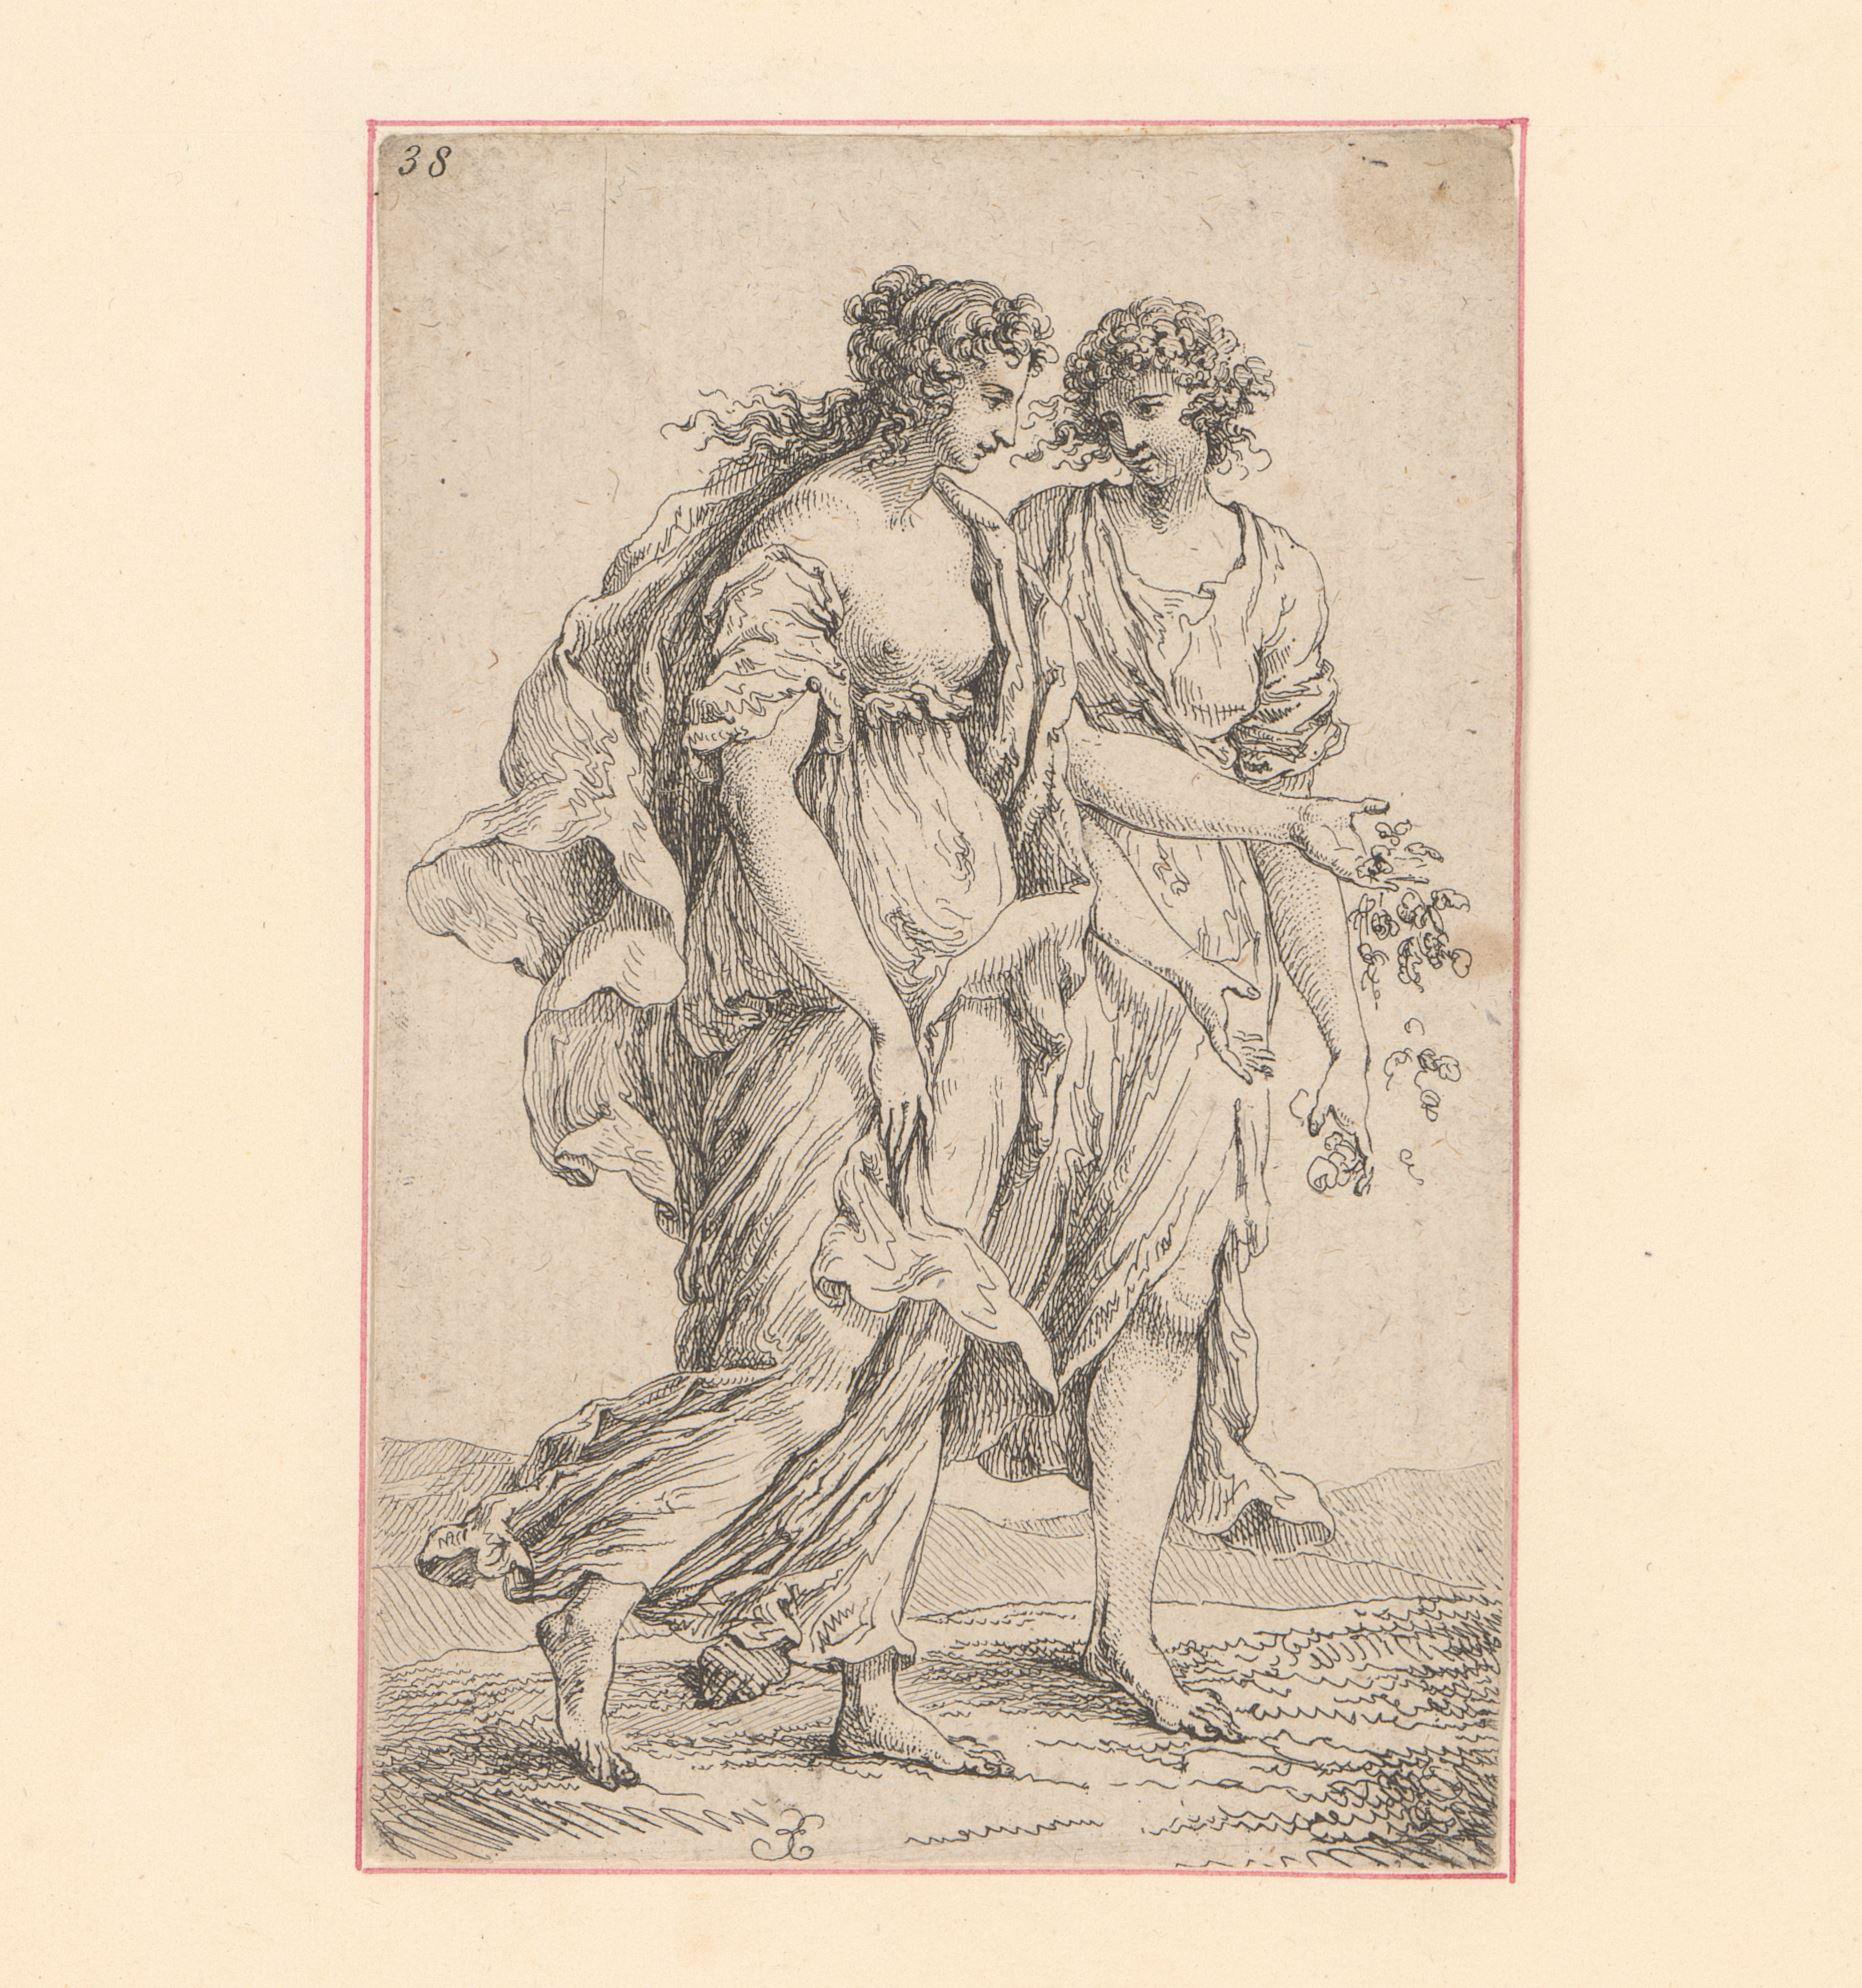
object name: album leaf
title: Etchings by E. Edwards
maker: edward edwards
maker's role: painter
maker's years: 1738-1806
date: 1748-1806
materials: paper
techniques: etching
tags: standing figure - aa - female human figure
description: Prent maakt deel uit van een serie van 51 prenten, bestaande uit twee delen met landschappen (36 prenten) en figuren en portretten (15 prenten), voor het eerst uitgegeven in Londen in 1790.